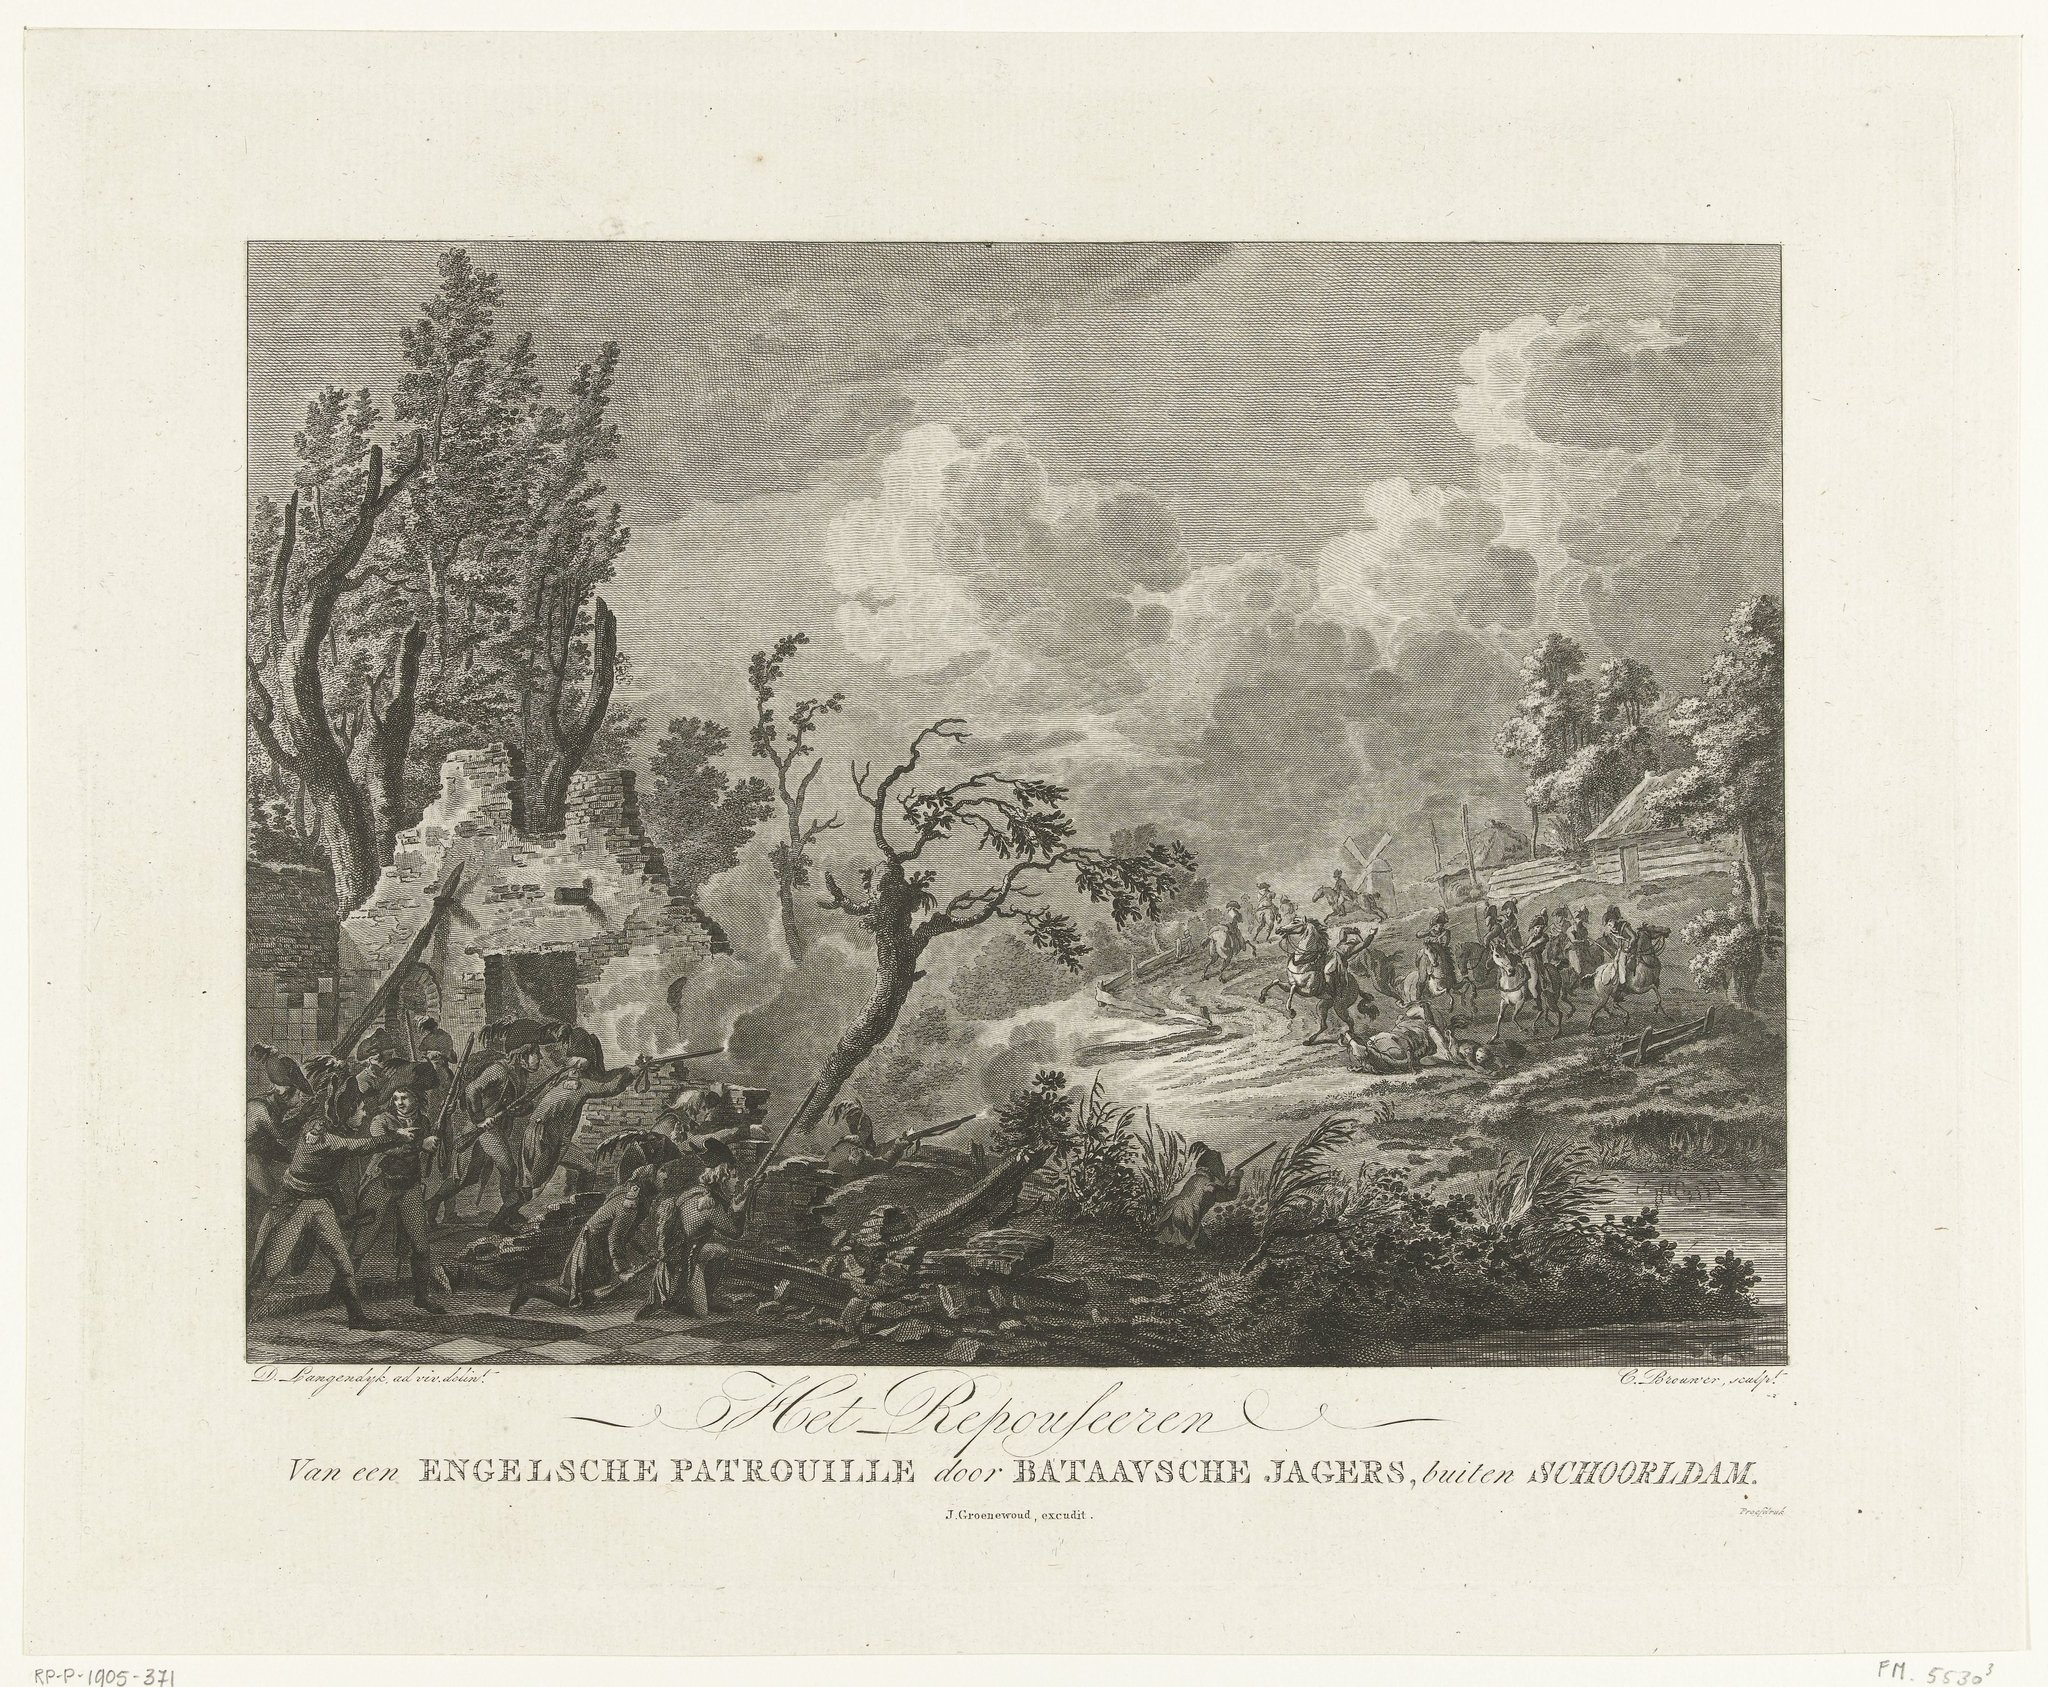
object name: print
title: Het repouseeren van een Engelsche Patrouille door Bataavsche Jagers, buiten Schoorldam.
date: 1799-1803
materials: paper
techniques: etching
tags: warfare; military affairs (+ during the battle)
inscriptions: collector's mark: Lugt 2228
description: Prent naar tekening van Jan Anthonie Langendijk. Prent uit serie van vier prenten met de Oorlog van het Frans-Bataafse leger tegen de Russen en Engelsen in 1799.